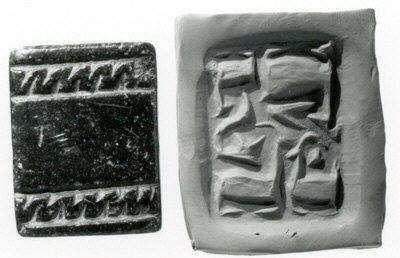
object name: stamp seal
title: Rectangular plaque seal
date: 3100-2900 BCE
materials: mineral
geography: mesopotamia or syria